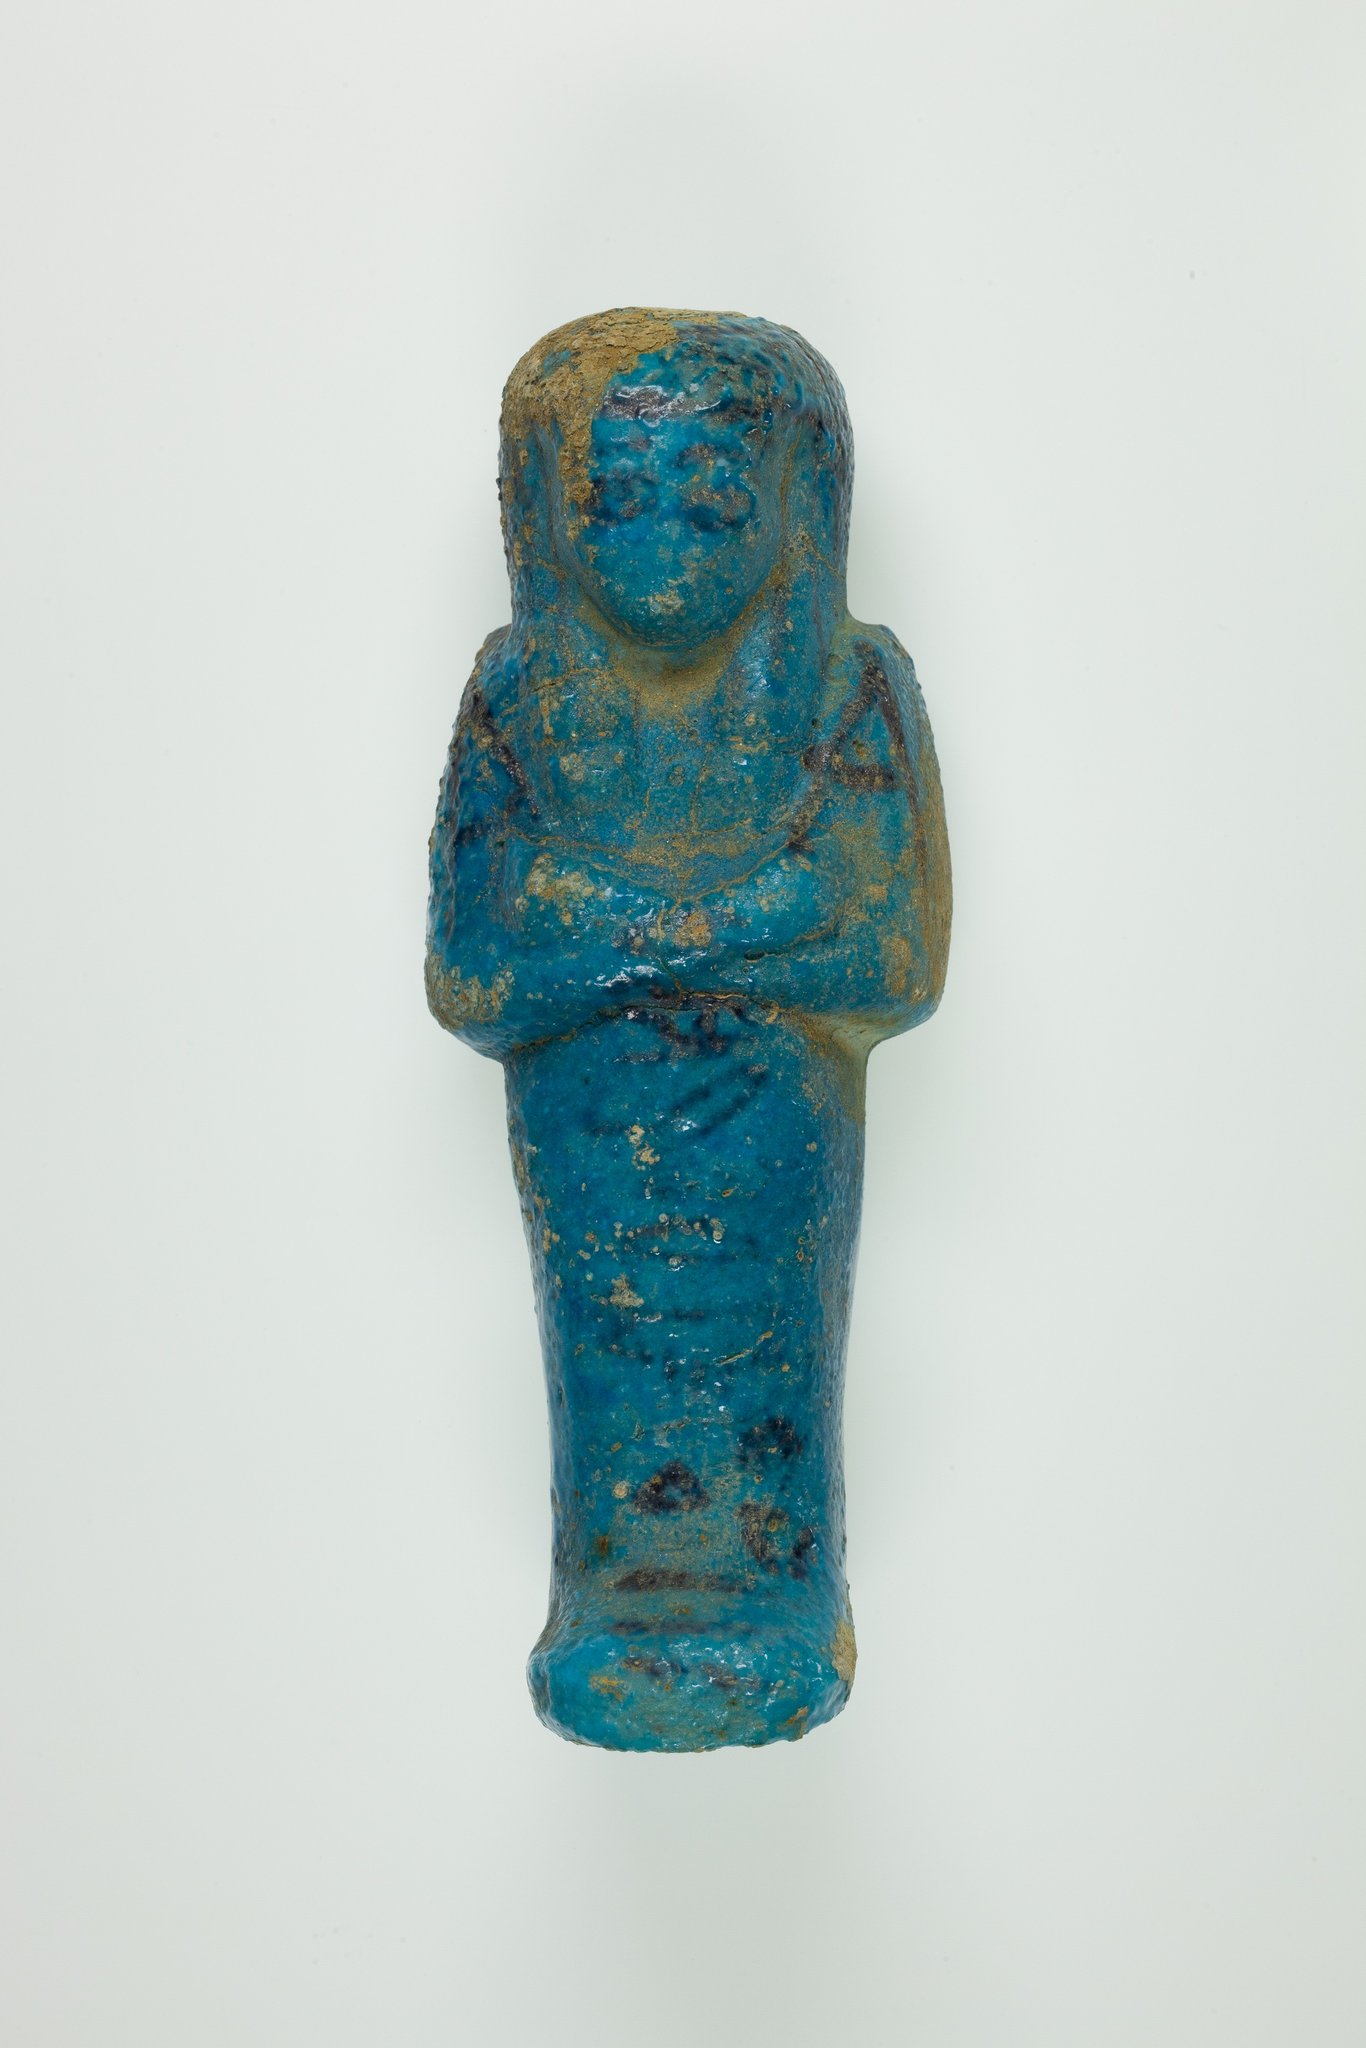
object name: worker shabti, henettawy c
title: Worker Shabti of Henettawy (C), Daughter of Isetemkheb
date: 990-970 BCE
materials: faience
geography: egypt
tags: hieroglyphs